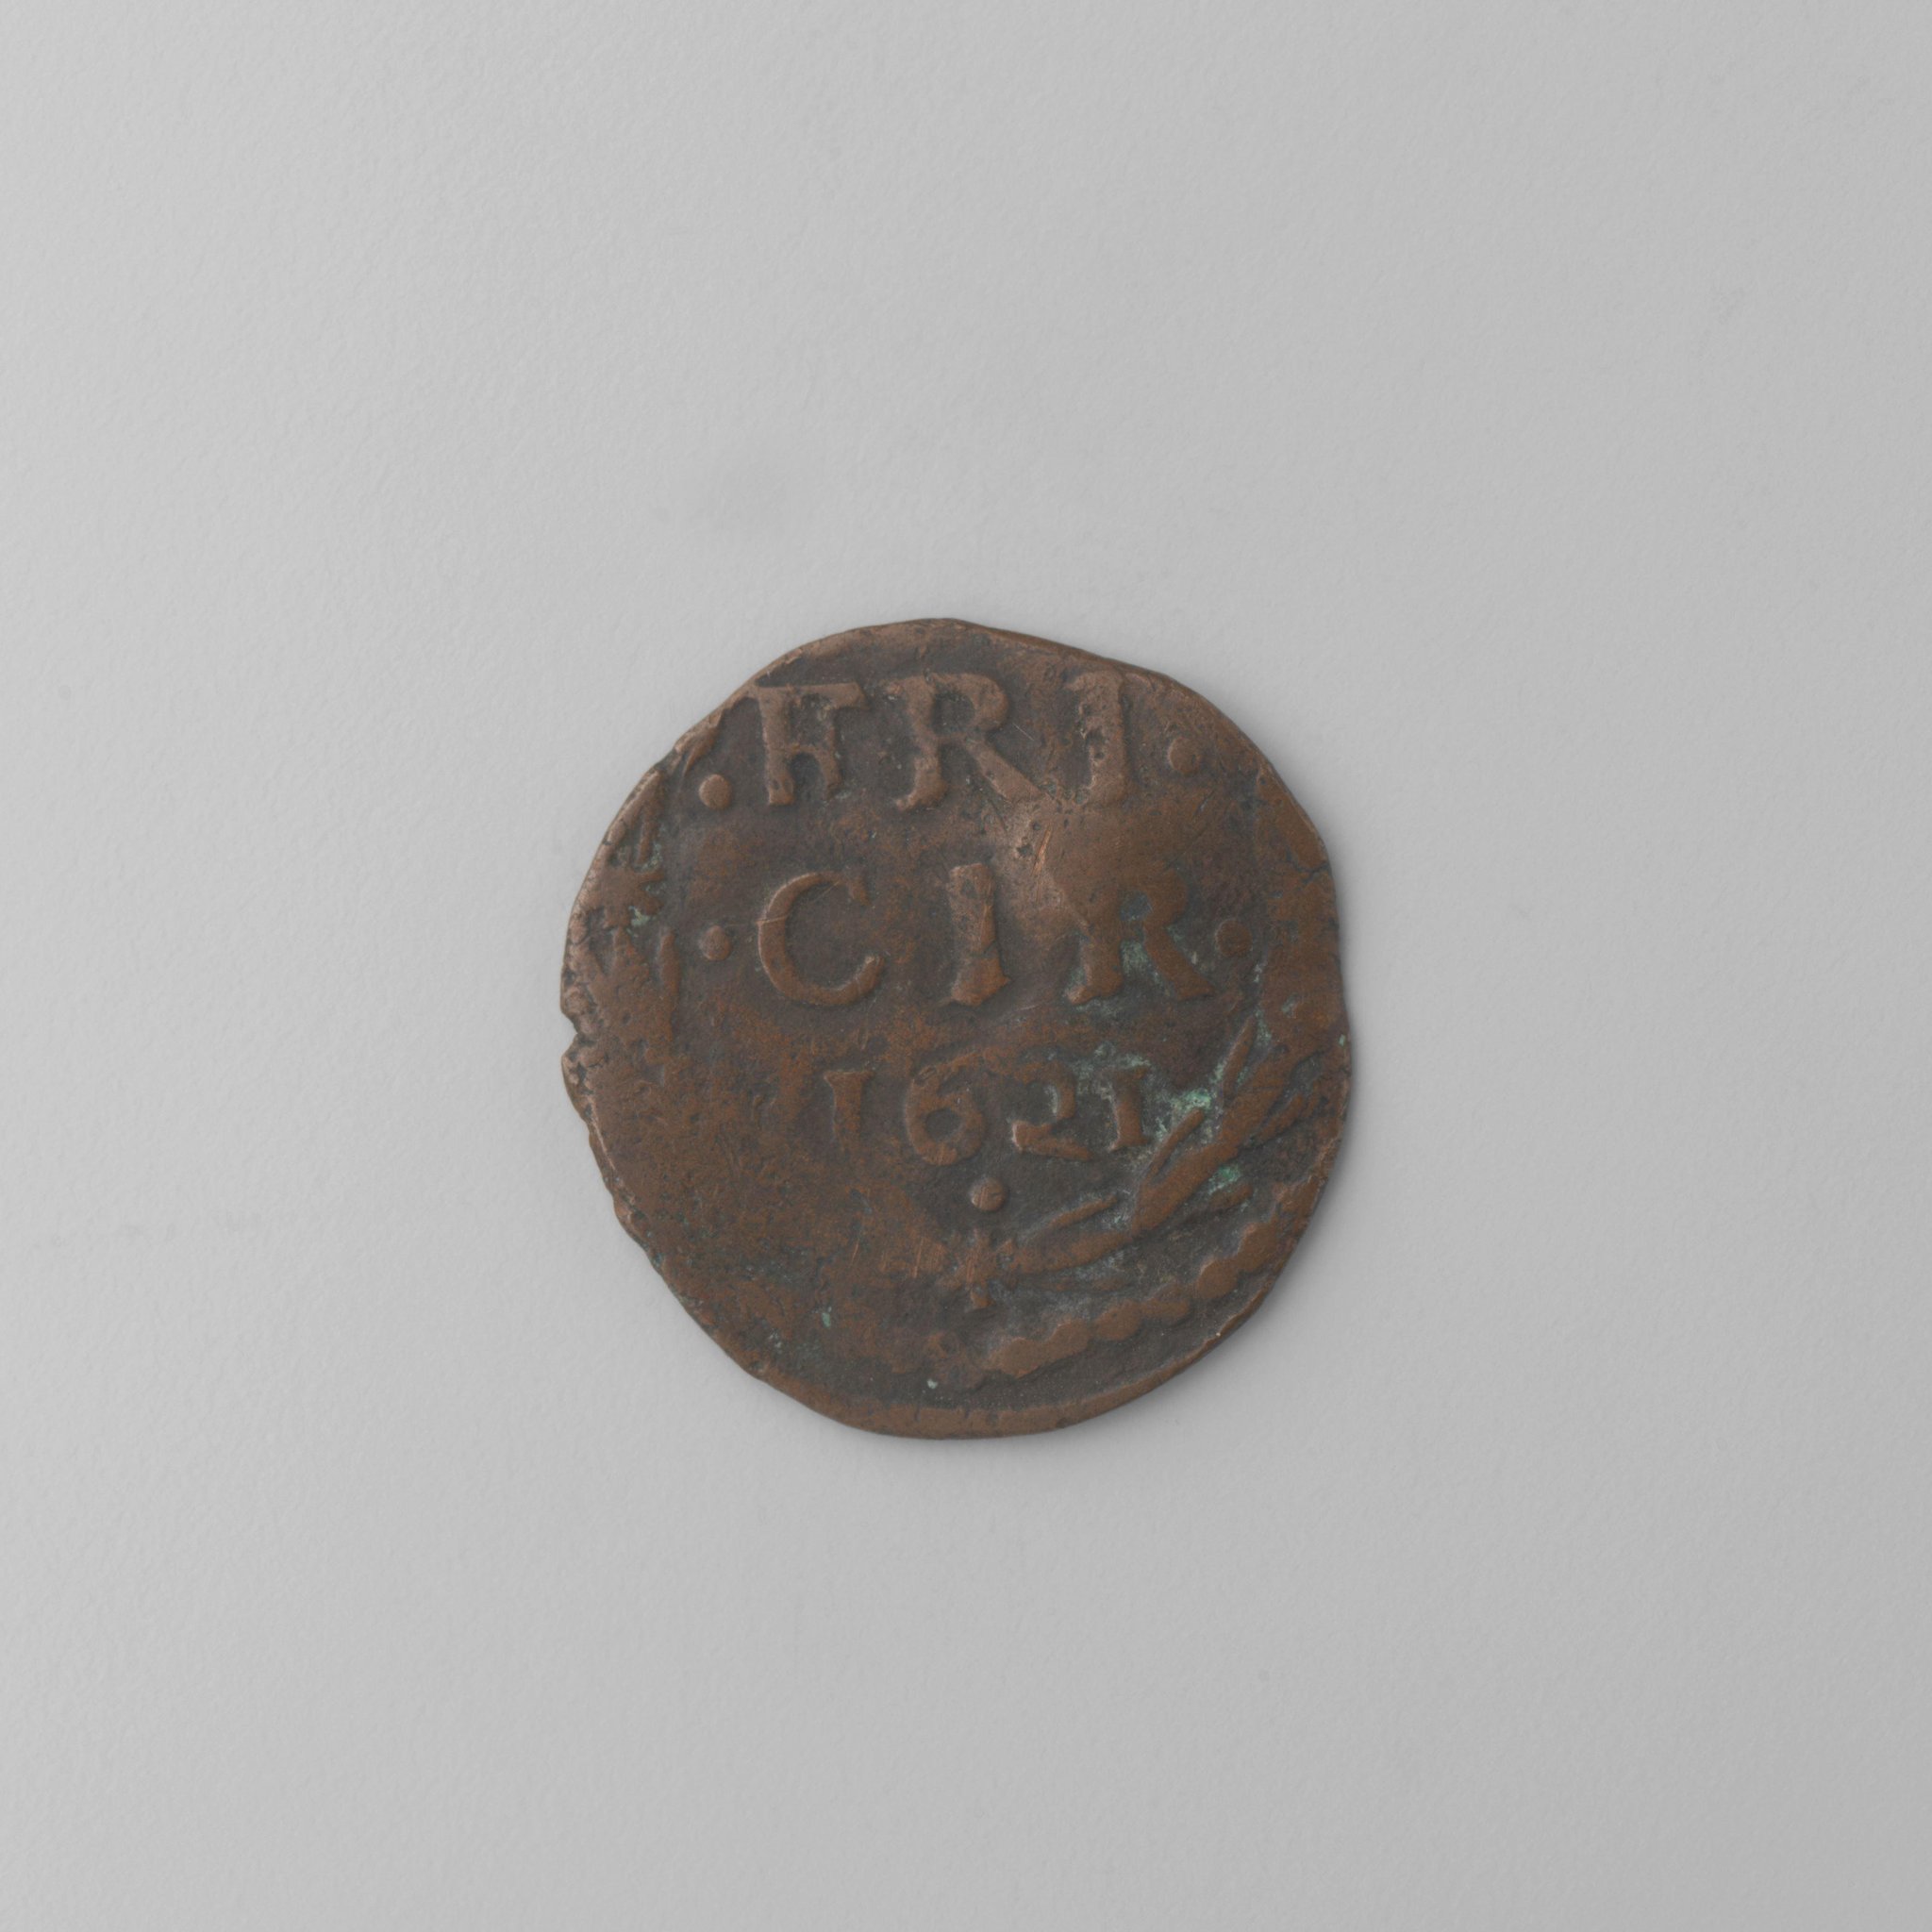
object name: coin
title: Reckheim, Ferdinand van Aspremont-Lynden (1636-1665), duit, 1621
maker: heer van reckheim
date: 1621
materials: copper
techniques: striking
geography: rekem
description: Koperen munt. Voorzijde: versierd wapenschild van Friesland, onder het schild vijf rondjes. Keerzijde: binnen een krans twee-regelig opschrift, waaronder jaartal.